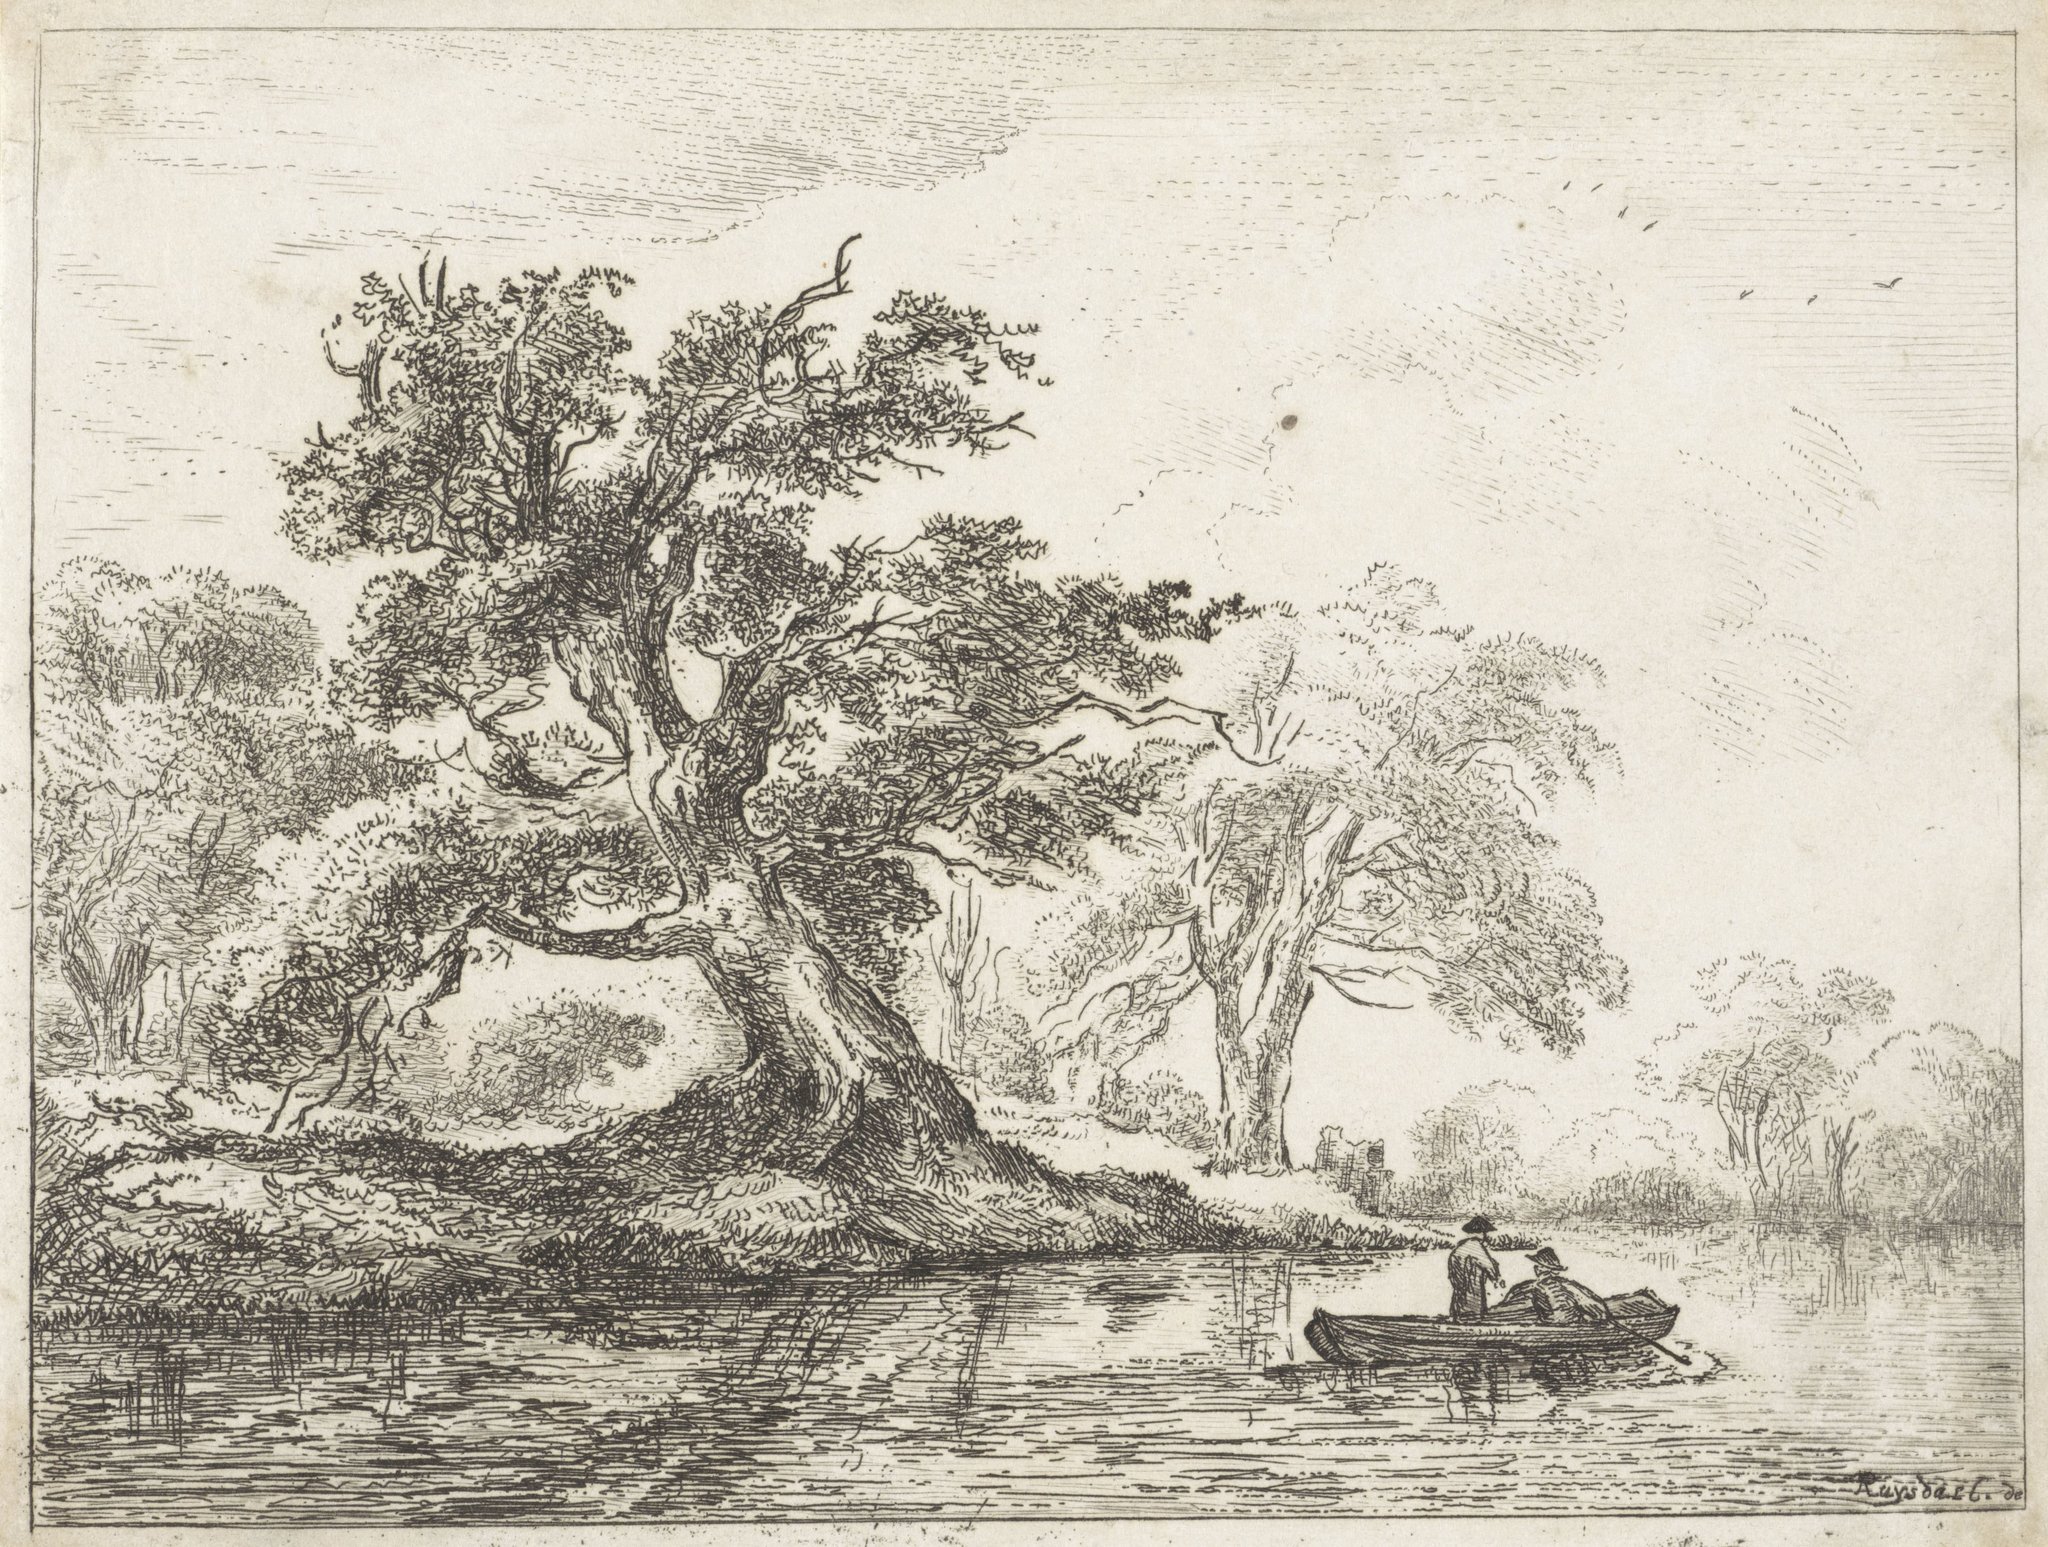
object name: print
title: Rivierlandschap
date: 1800-1875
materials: paper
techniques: etching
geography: netherlands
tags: river, rowing-boat, canoe, etc.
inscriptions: collector's mark: Lugt 2760, collector's mark: Lugt 2228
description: Door een boomrijk landschap stroomt een brede rivier. In het midden een roeiboot met twee figuren.